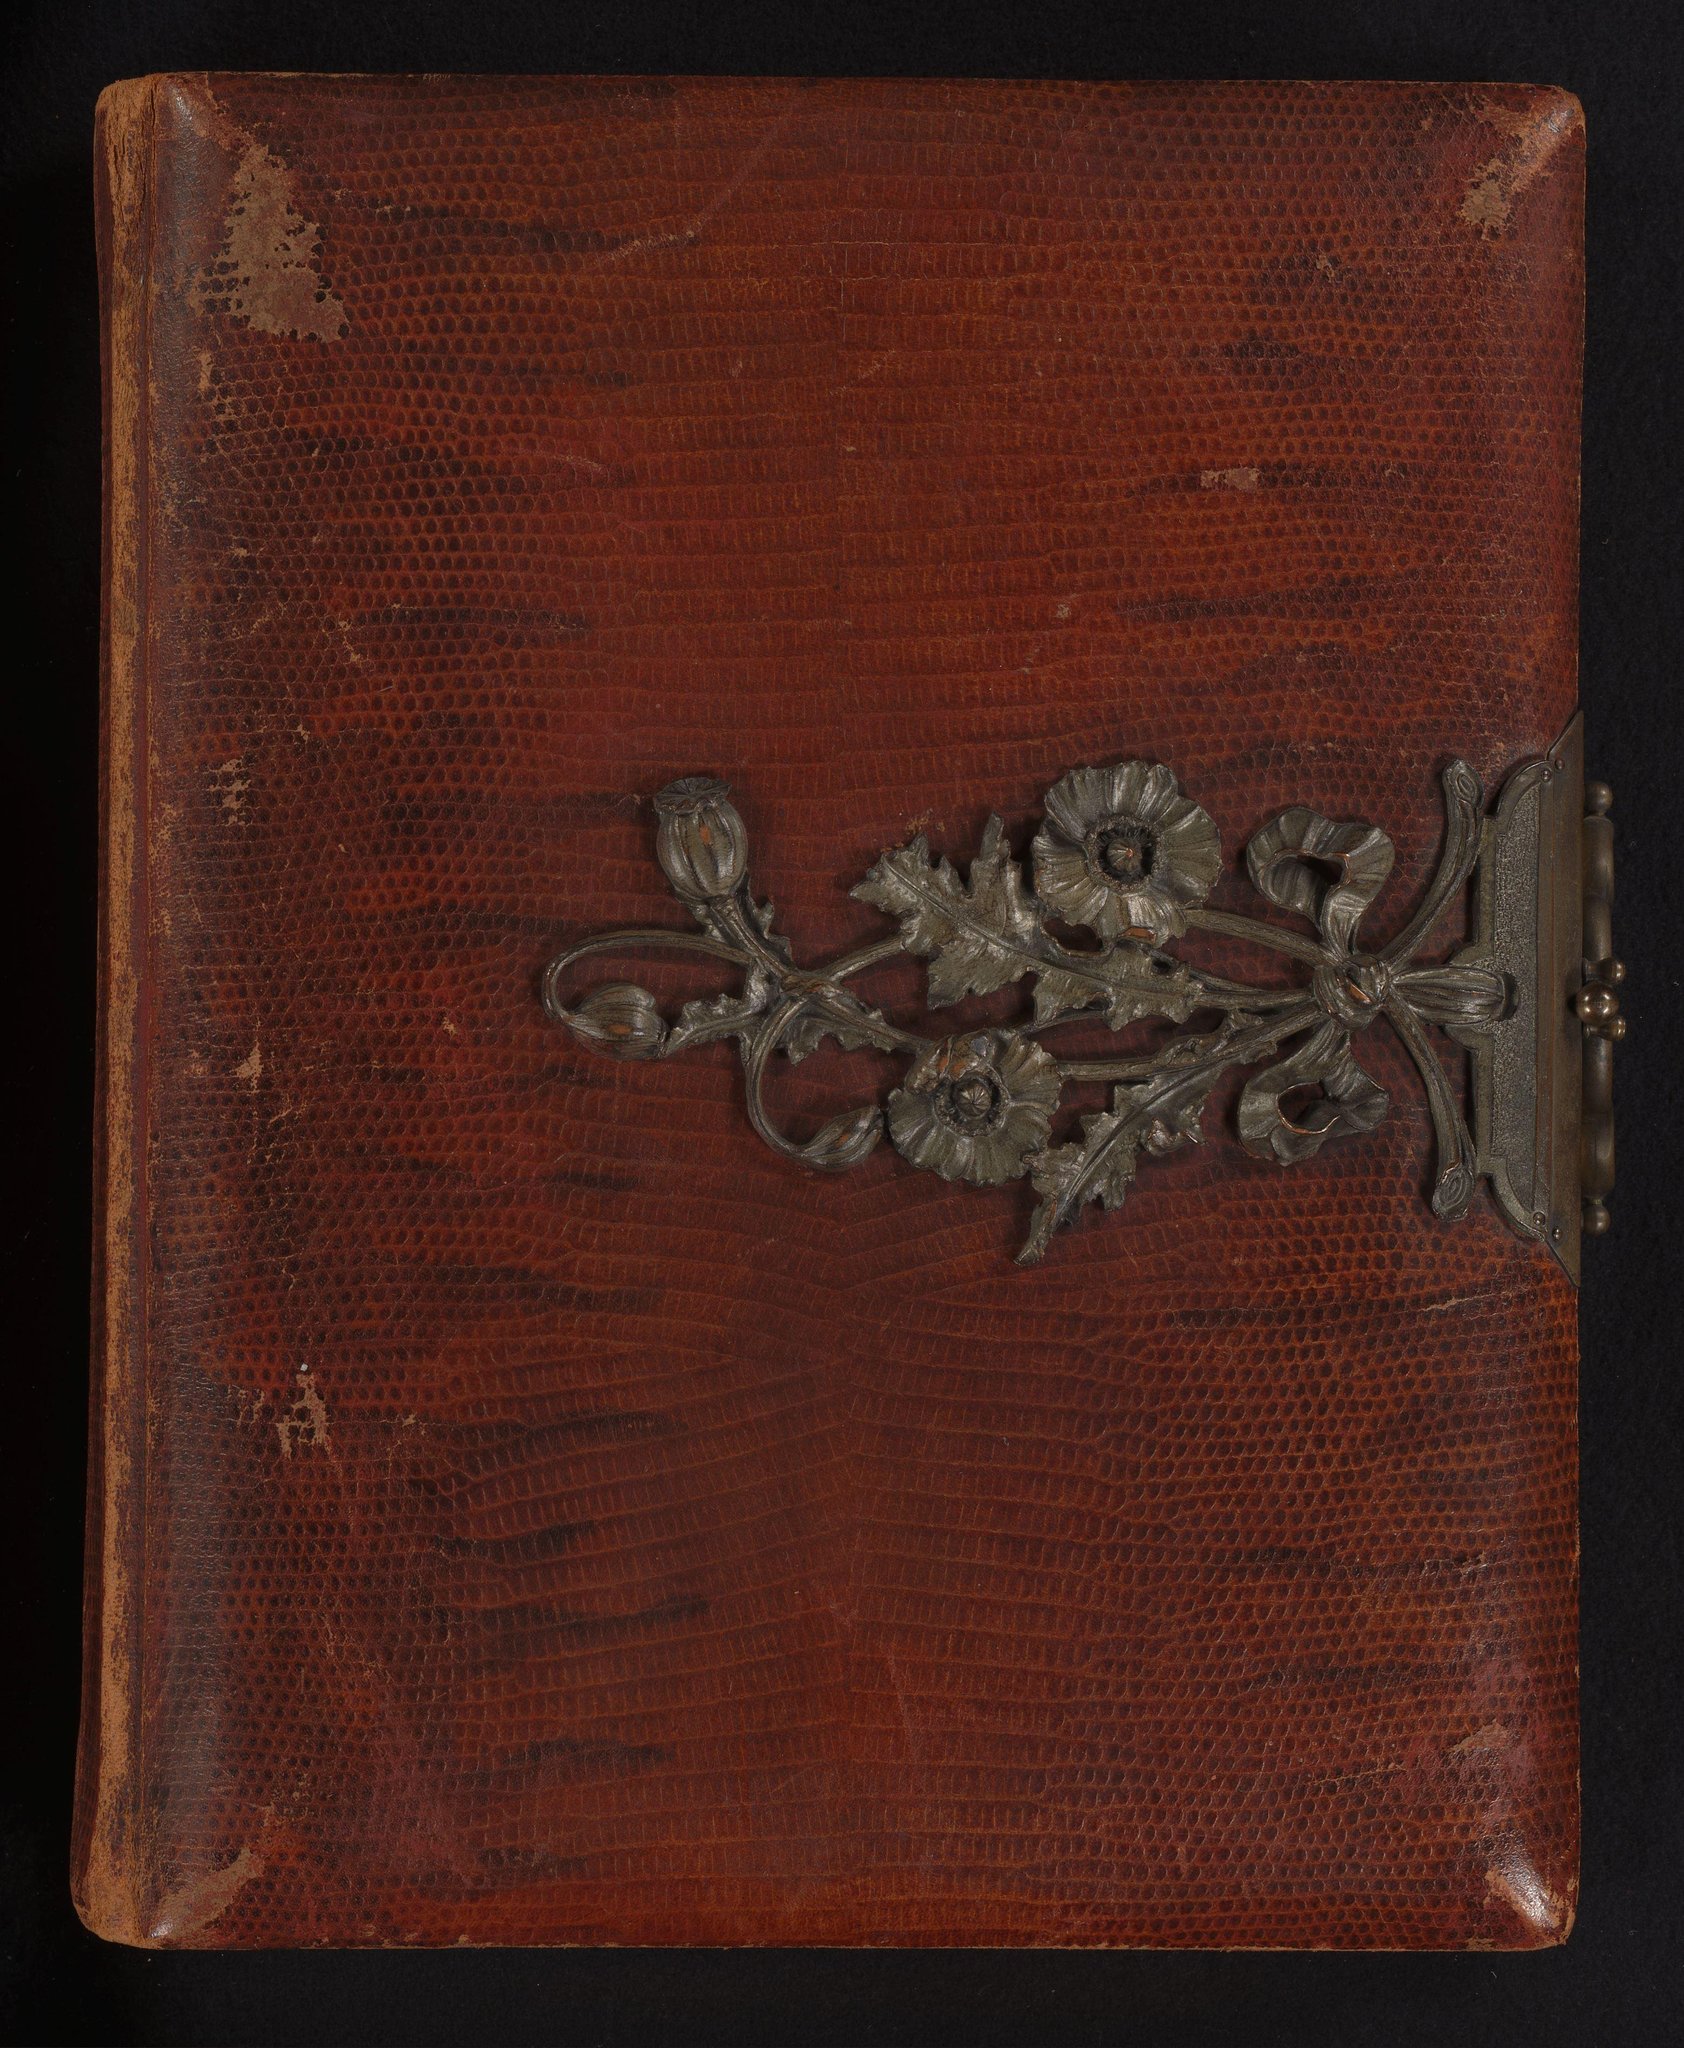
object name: photograph album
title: Fotoalbum met 26 foto's van bekende personen en 2 fotoreproducties van schilderijen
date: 1860-1920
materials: cardboard, copper, leather, paper, photographic support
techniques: albumen print, photograph, decorated paper, gelatin silver print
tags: historical persons - bb - woman, president ~ head of republic, commander-in-chief, general, marshal, historical persons, queen, king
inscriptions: annotation: ‘35,-/ 6738107’, collector's mark: ‘Dienst Verspreide Rijkskollekties (...) A 673’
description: Fotoalbum met portretten van bekende personen. Het album bevat 15 bladen met goud op snee en insteek passe-partouts met kabinetkaarten. Elke pagina bevat 1 portret met uitzondering van 2 reproducties van schilderijen. In totaal bevat het album 26 portretten van bekende personen, waaronder leden van het koningshuis zoals: Alexander III van Rusland, Elisabeth in Beieren, Frans Jozef I van Oostenrijk en koning Rama V van Thailand. Daarnaast enkele staatshoofden en generaals zoals: president Chester Arthur, Georges Boulanger en Paul von Hindenburg. De 2 fotoreproducties zijn van schilderijen van Georg Bleibtreu met betrekking tot de Frans-Duitse oorlog. Een deel van de vervaardigers is anoniem, enkele bekende vervaardigers zijn: Wegner & Mottu, Carjat et Cie. en Othmar van Türk.